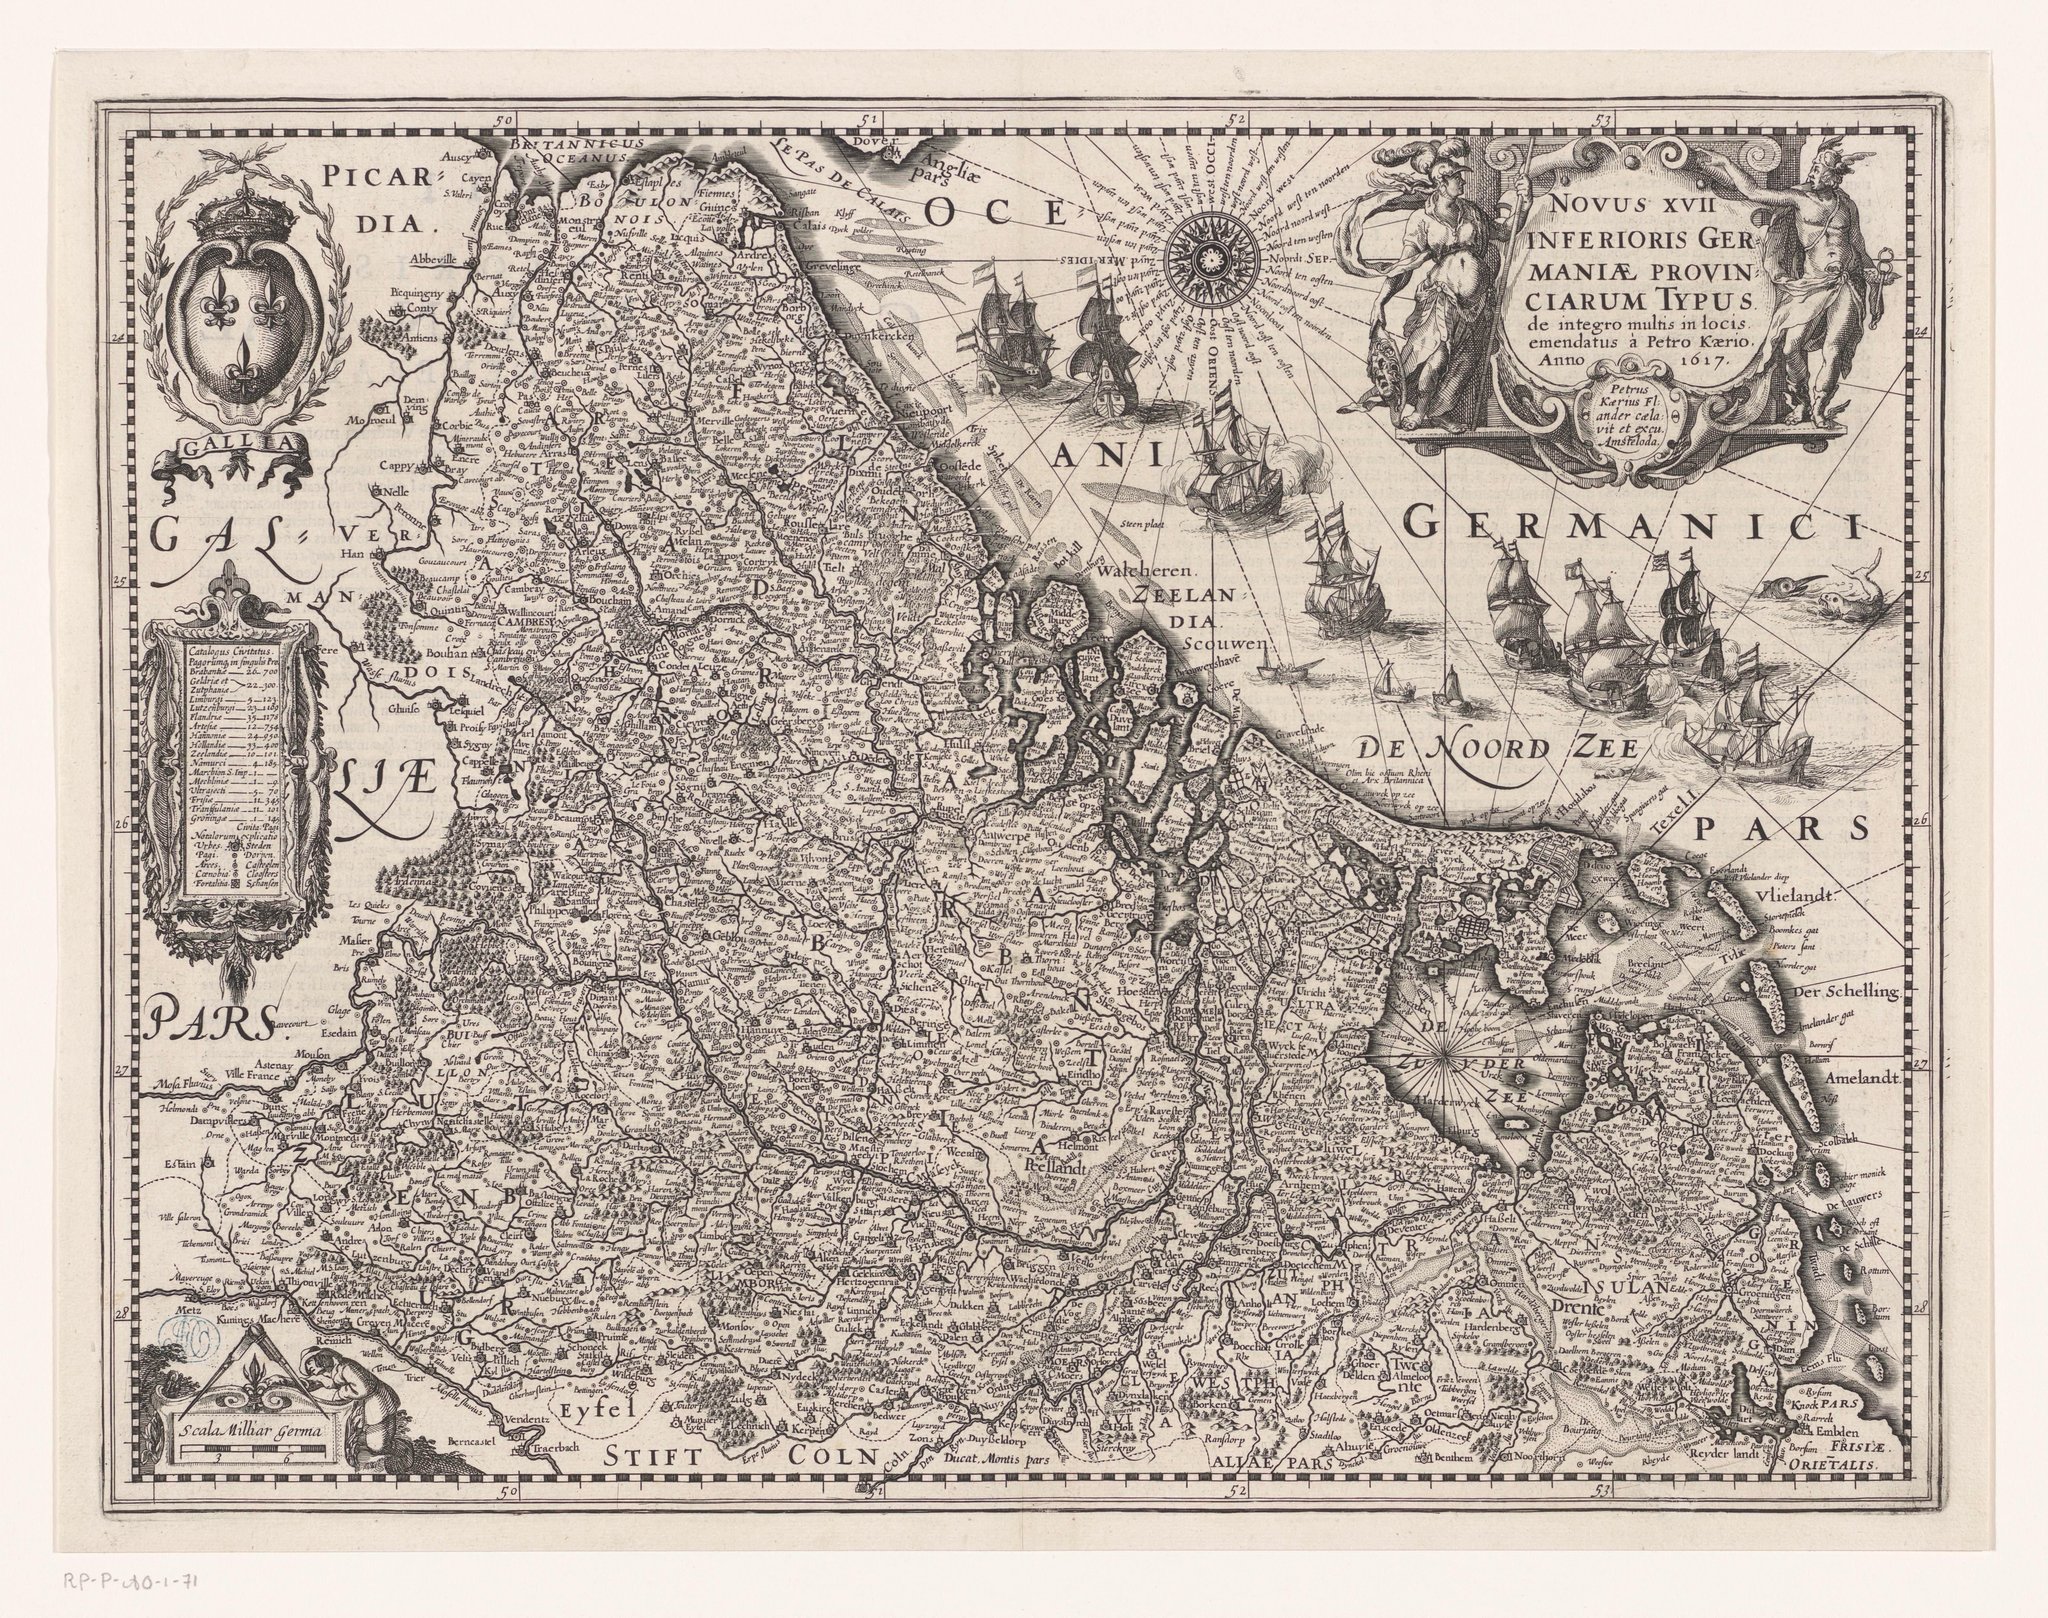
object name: print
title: Novus XVII Inferioris Germaniae provinciarum typus (...)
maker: pieter van der keere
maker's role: print maker, publisher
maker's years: 1571-1646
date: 1617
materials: paper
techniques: engraving, etching, letterpress printing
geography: amsterdam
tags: coat of arms (as symbol of the state, etc.), maps of separate countries or regions, (story of) minerva (pallas, athena), (story of) mercury (hermes), low countries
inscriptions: collector's mark: Lugt 2228, collector's mark: Lugt 195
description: Linksboven cartouche met het wapen van Frankrijk, daaronder een cartouche met een overzicht van de provincies, topografische informatie en een legenda. Linksonder schaalstok: Scala milliar Germa. Rechtsboven titelcartouche waarnaast respectievelijk links en rechts Minerva en Mercurius staan afgebeeld. Gradenverdeling langs de randen. Oriëntatie: het noorden rechts. Op verso Latijnse tekst.